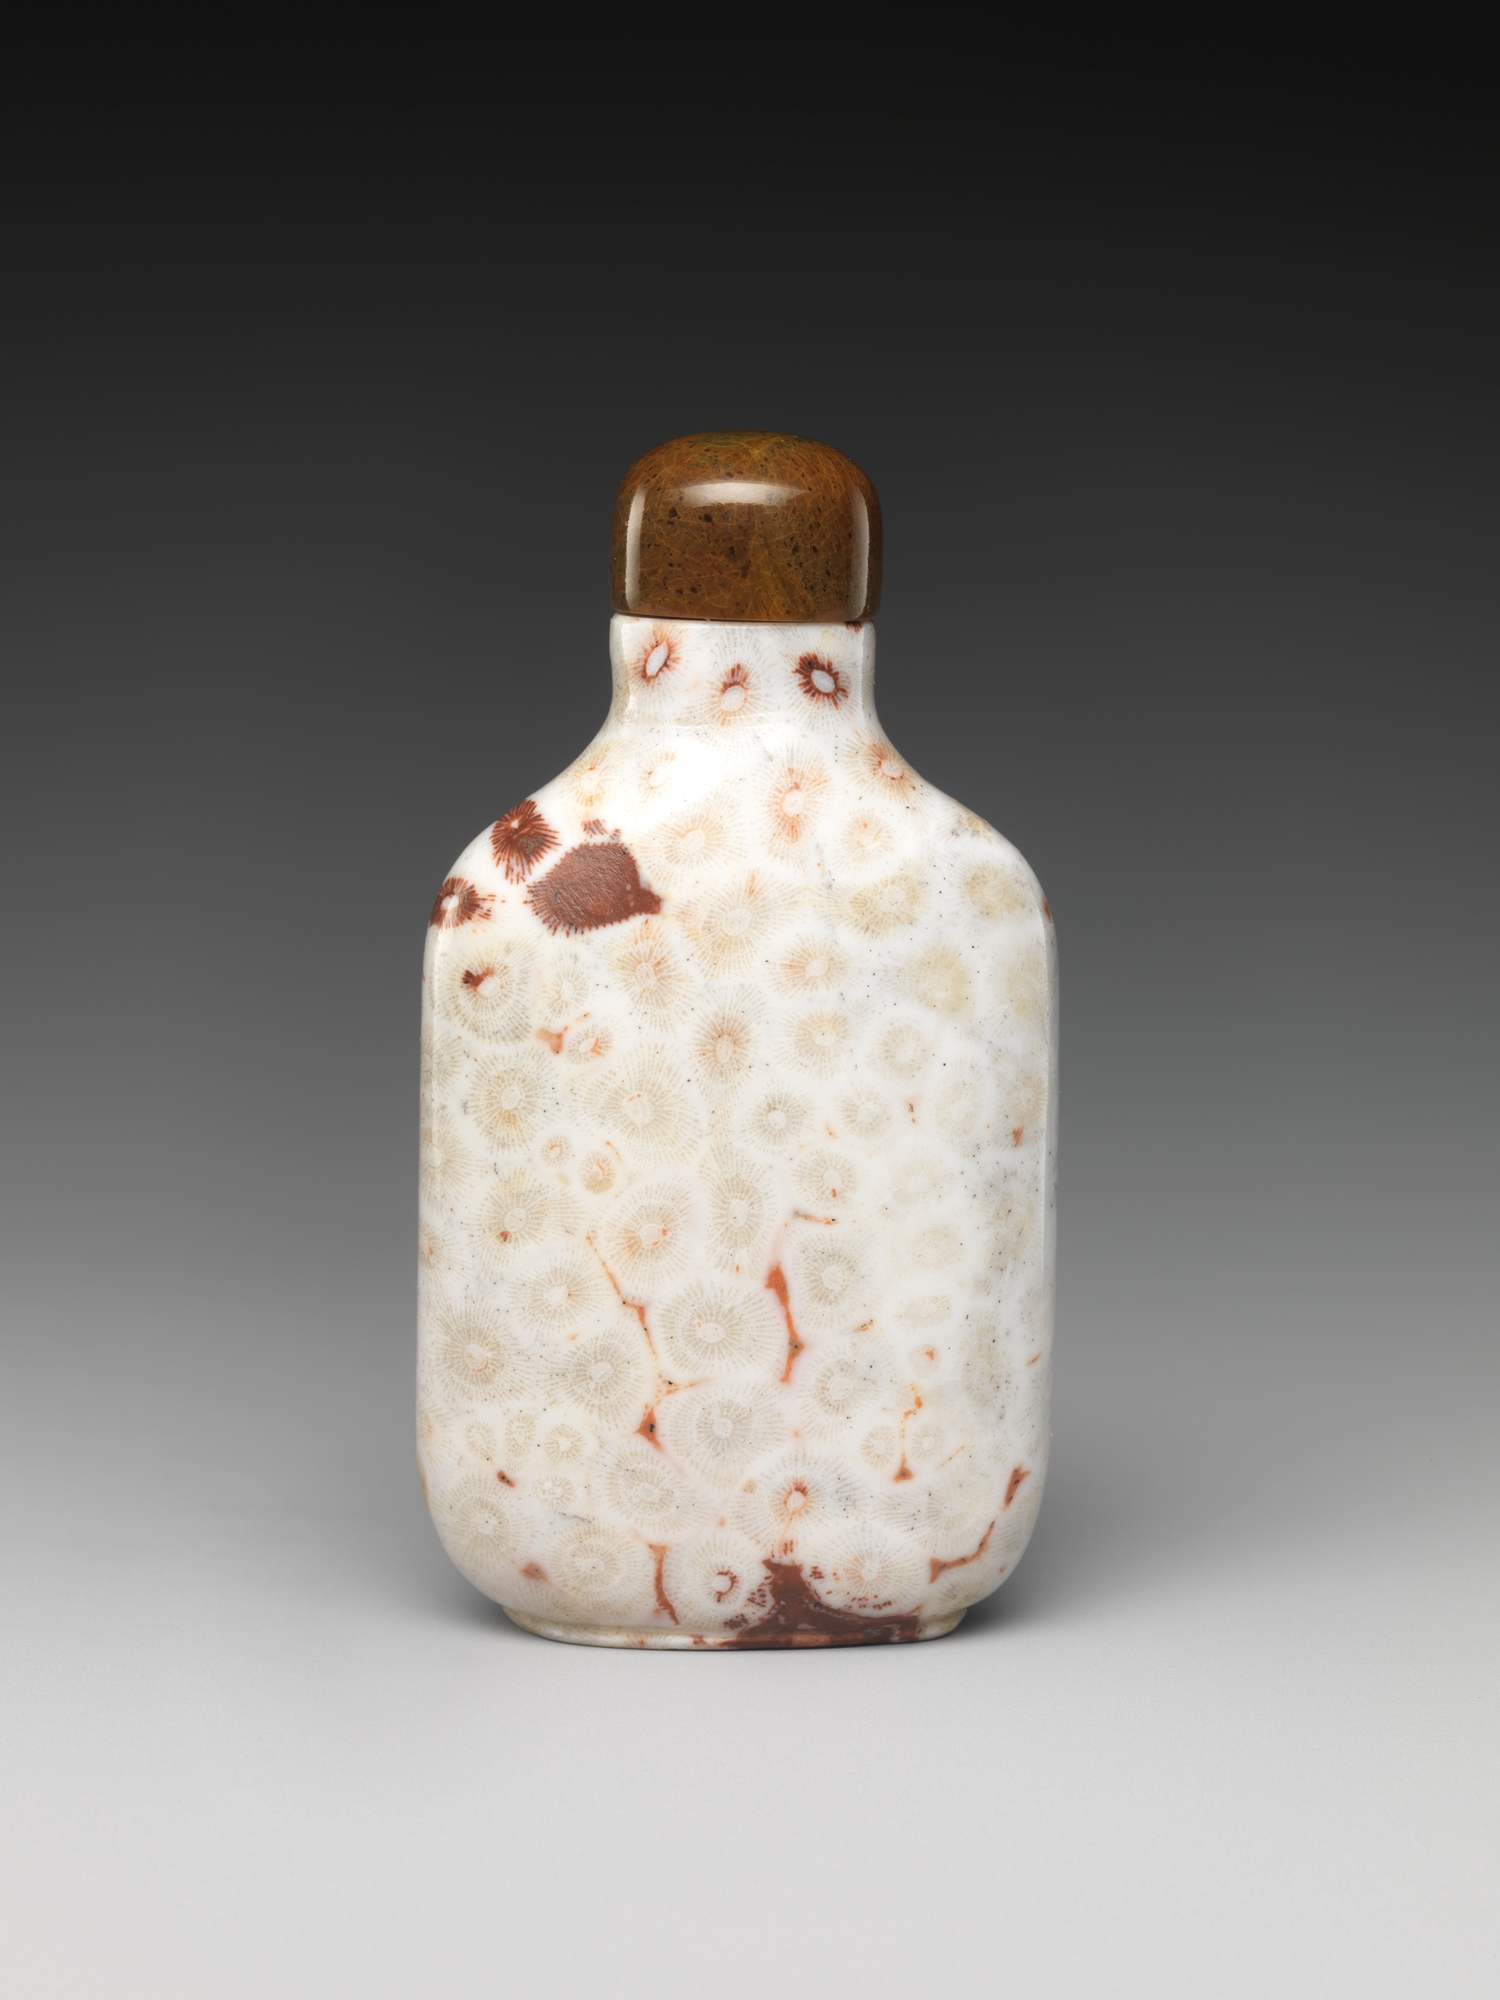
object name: snuff bottle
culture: chinese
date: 1801-1900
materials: amber, coral